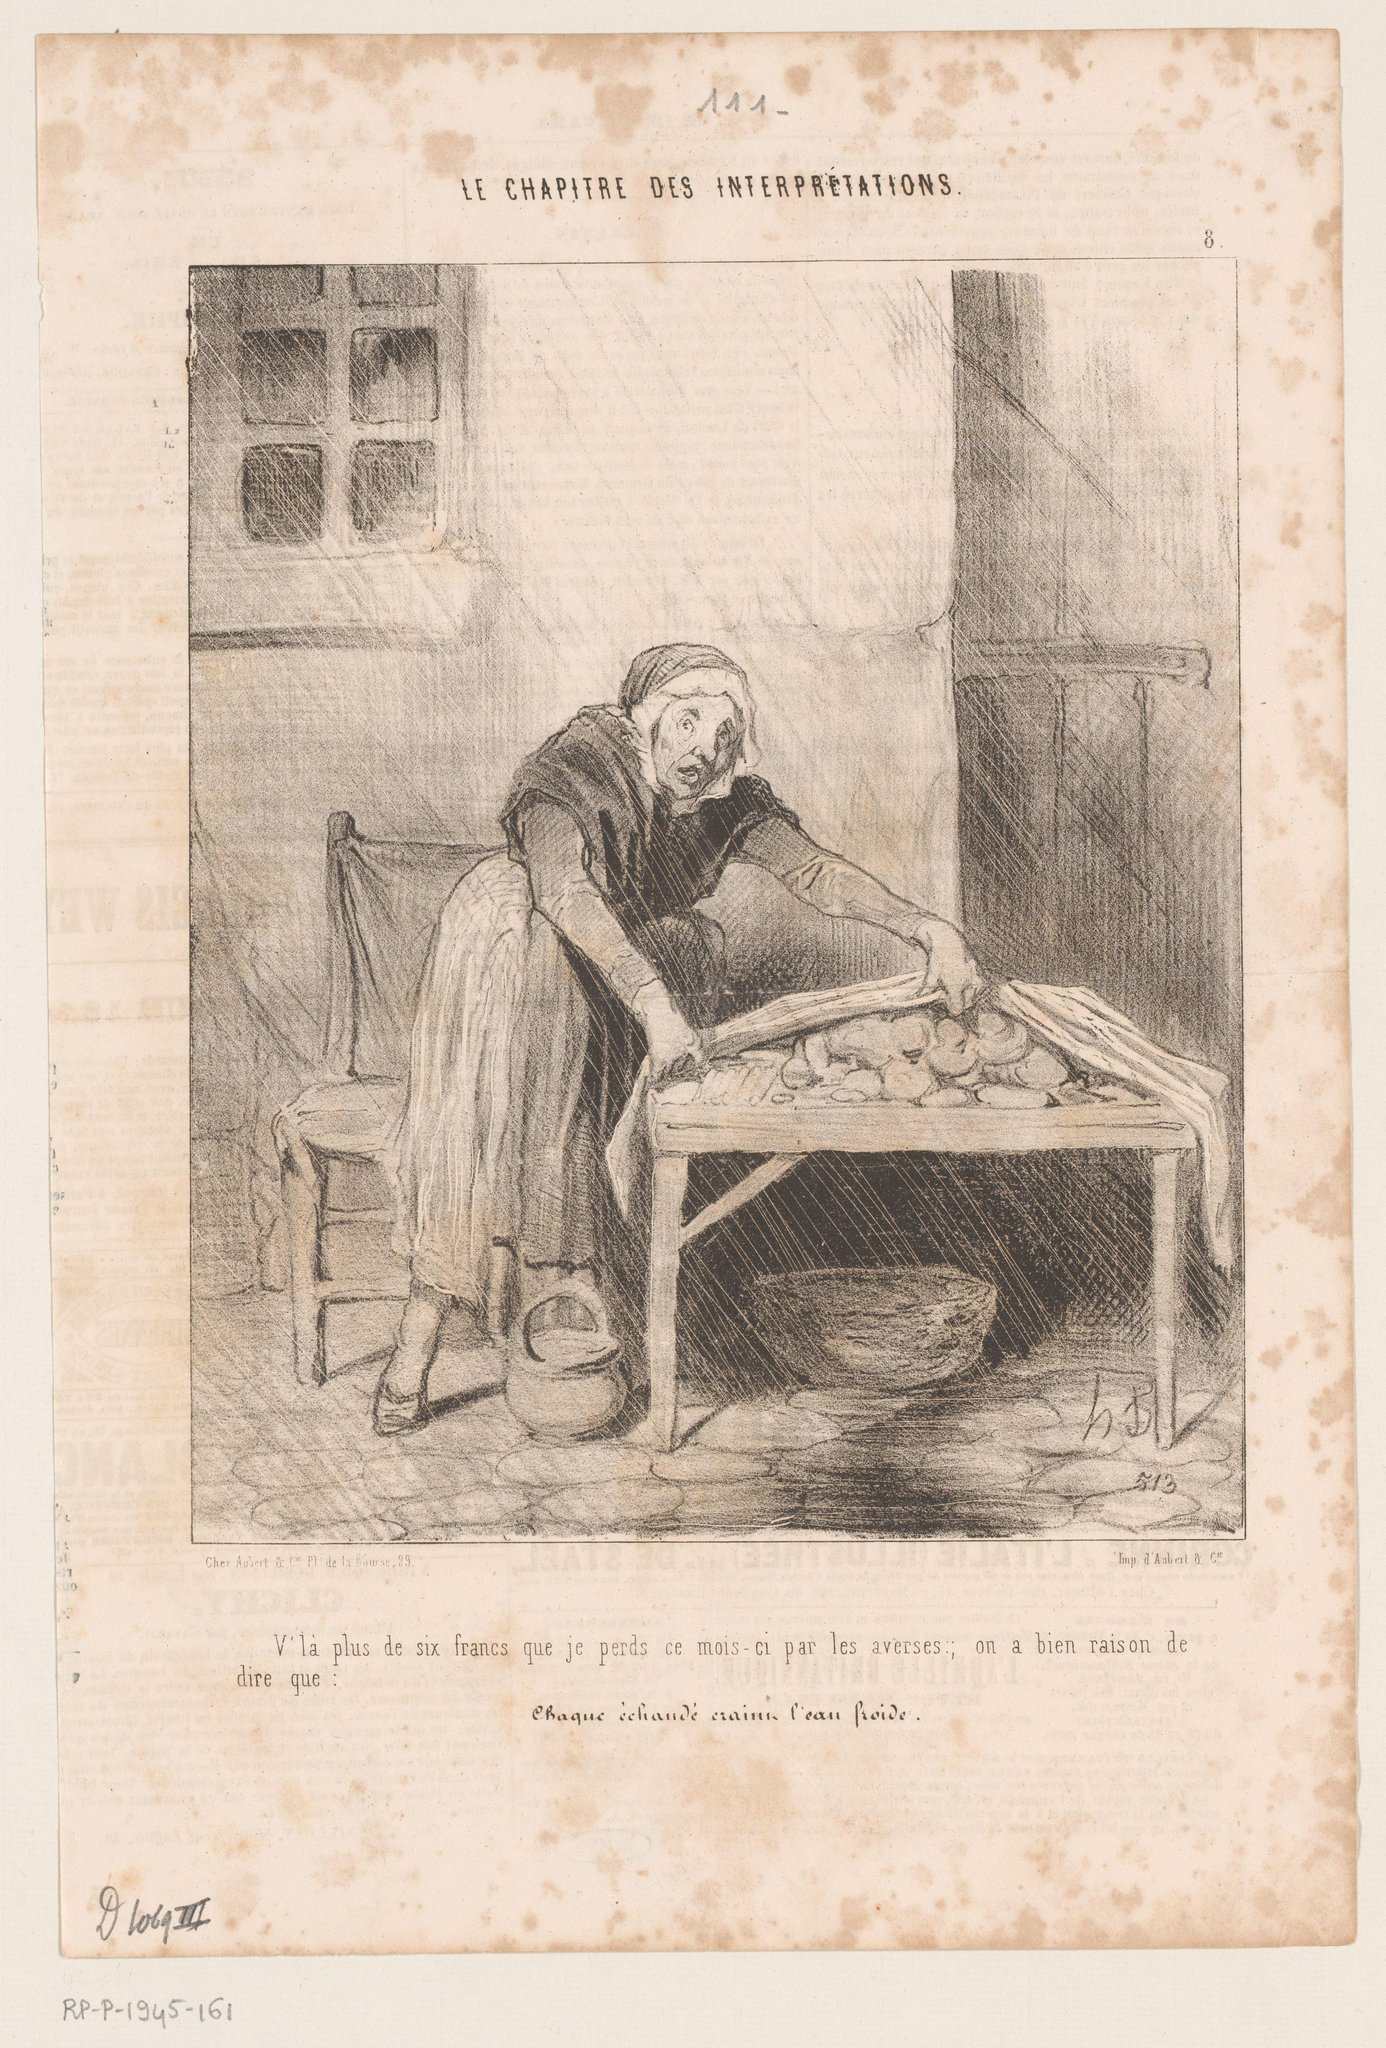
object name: cartoon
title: V'la plus de six francs que je perds (...)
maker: honoré daumier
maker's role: draughtsman, painter, print maker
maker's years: 1808-1879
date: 1843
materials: paper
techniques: lithograph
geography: paris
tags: caricatures (human types), street-trader - bb - women engaged in trade and commerce, rain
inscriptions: number: ‘111’, collector's mark: Lugt 2228a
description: Prent gepubliceerd in: Le Charivari, Aubert: Parijs, 24-11-1843. Le Charivari was een humoristische krant met karikaturen en (politieke) cartoons.